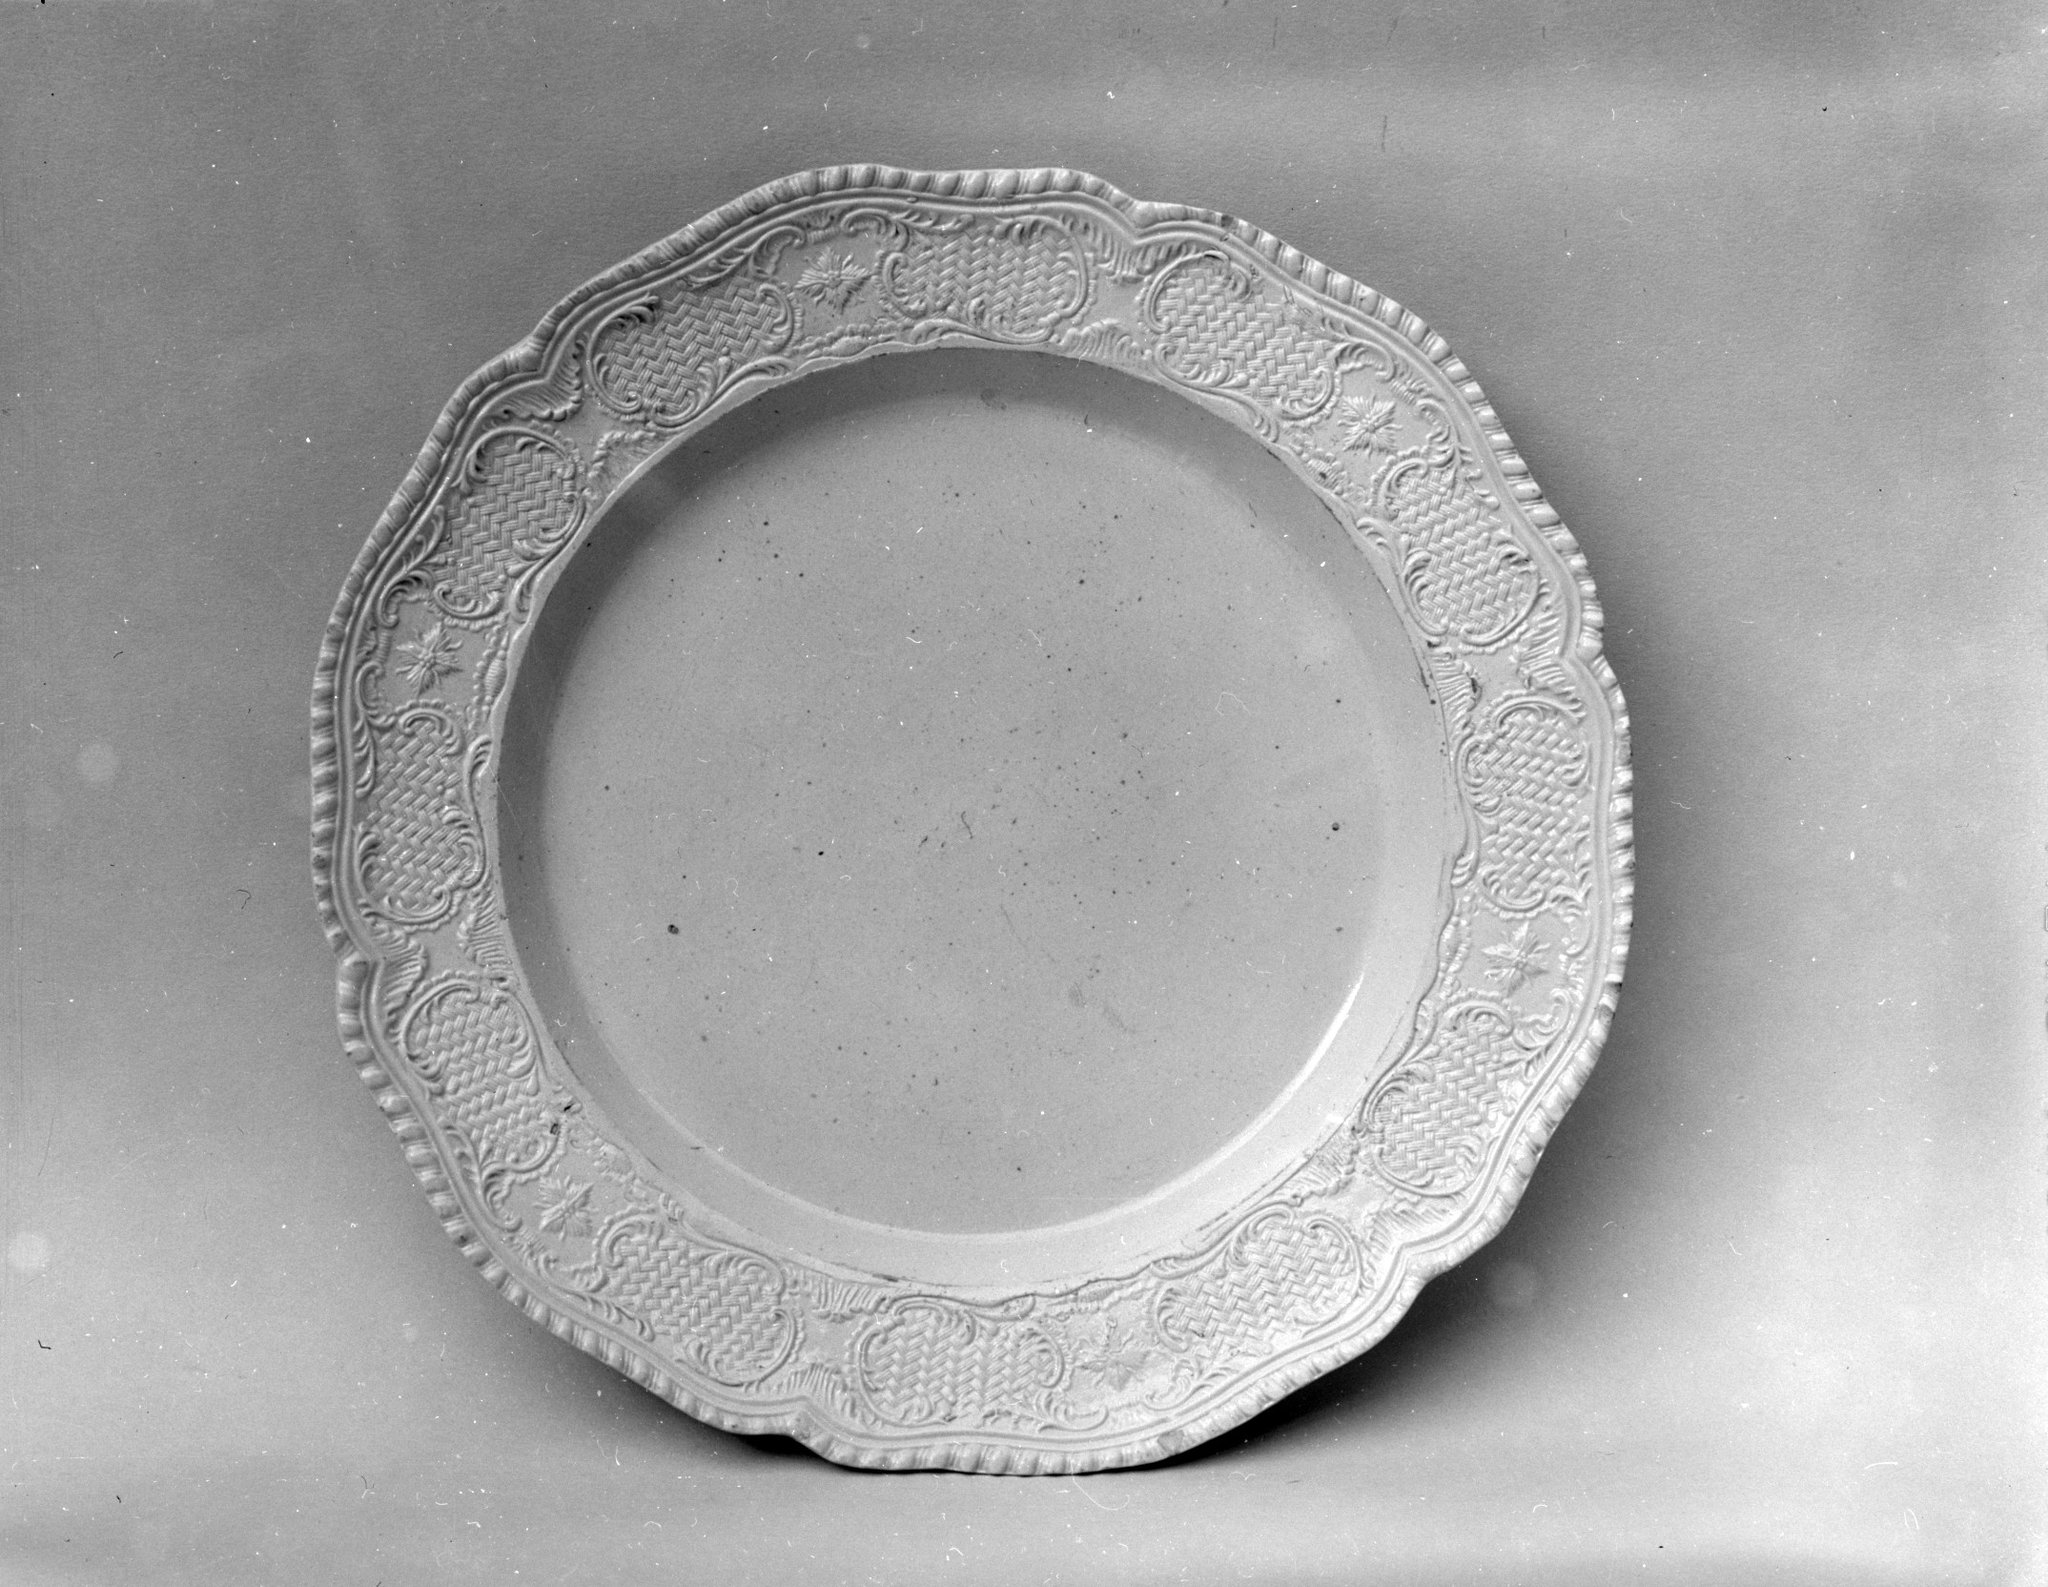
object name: plate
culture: british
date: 1750-1760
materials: stoneware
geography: england